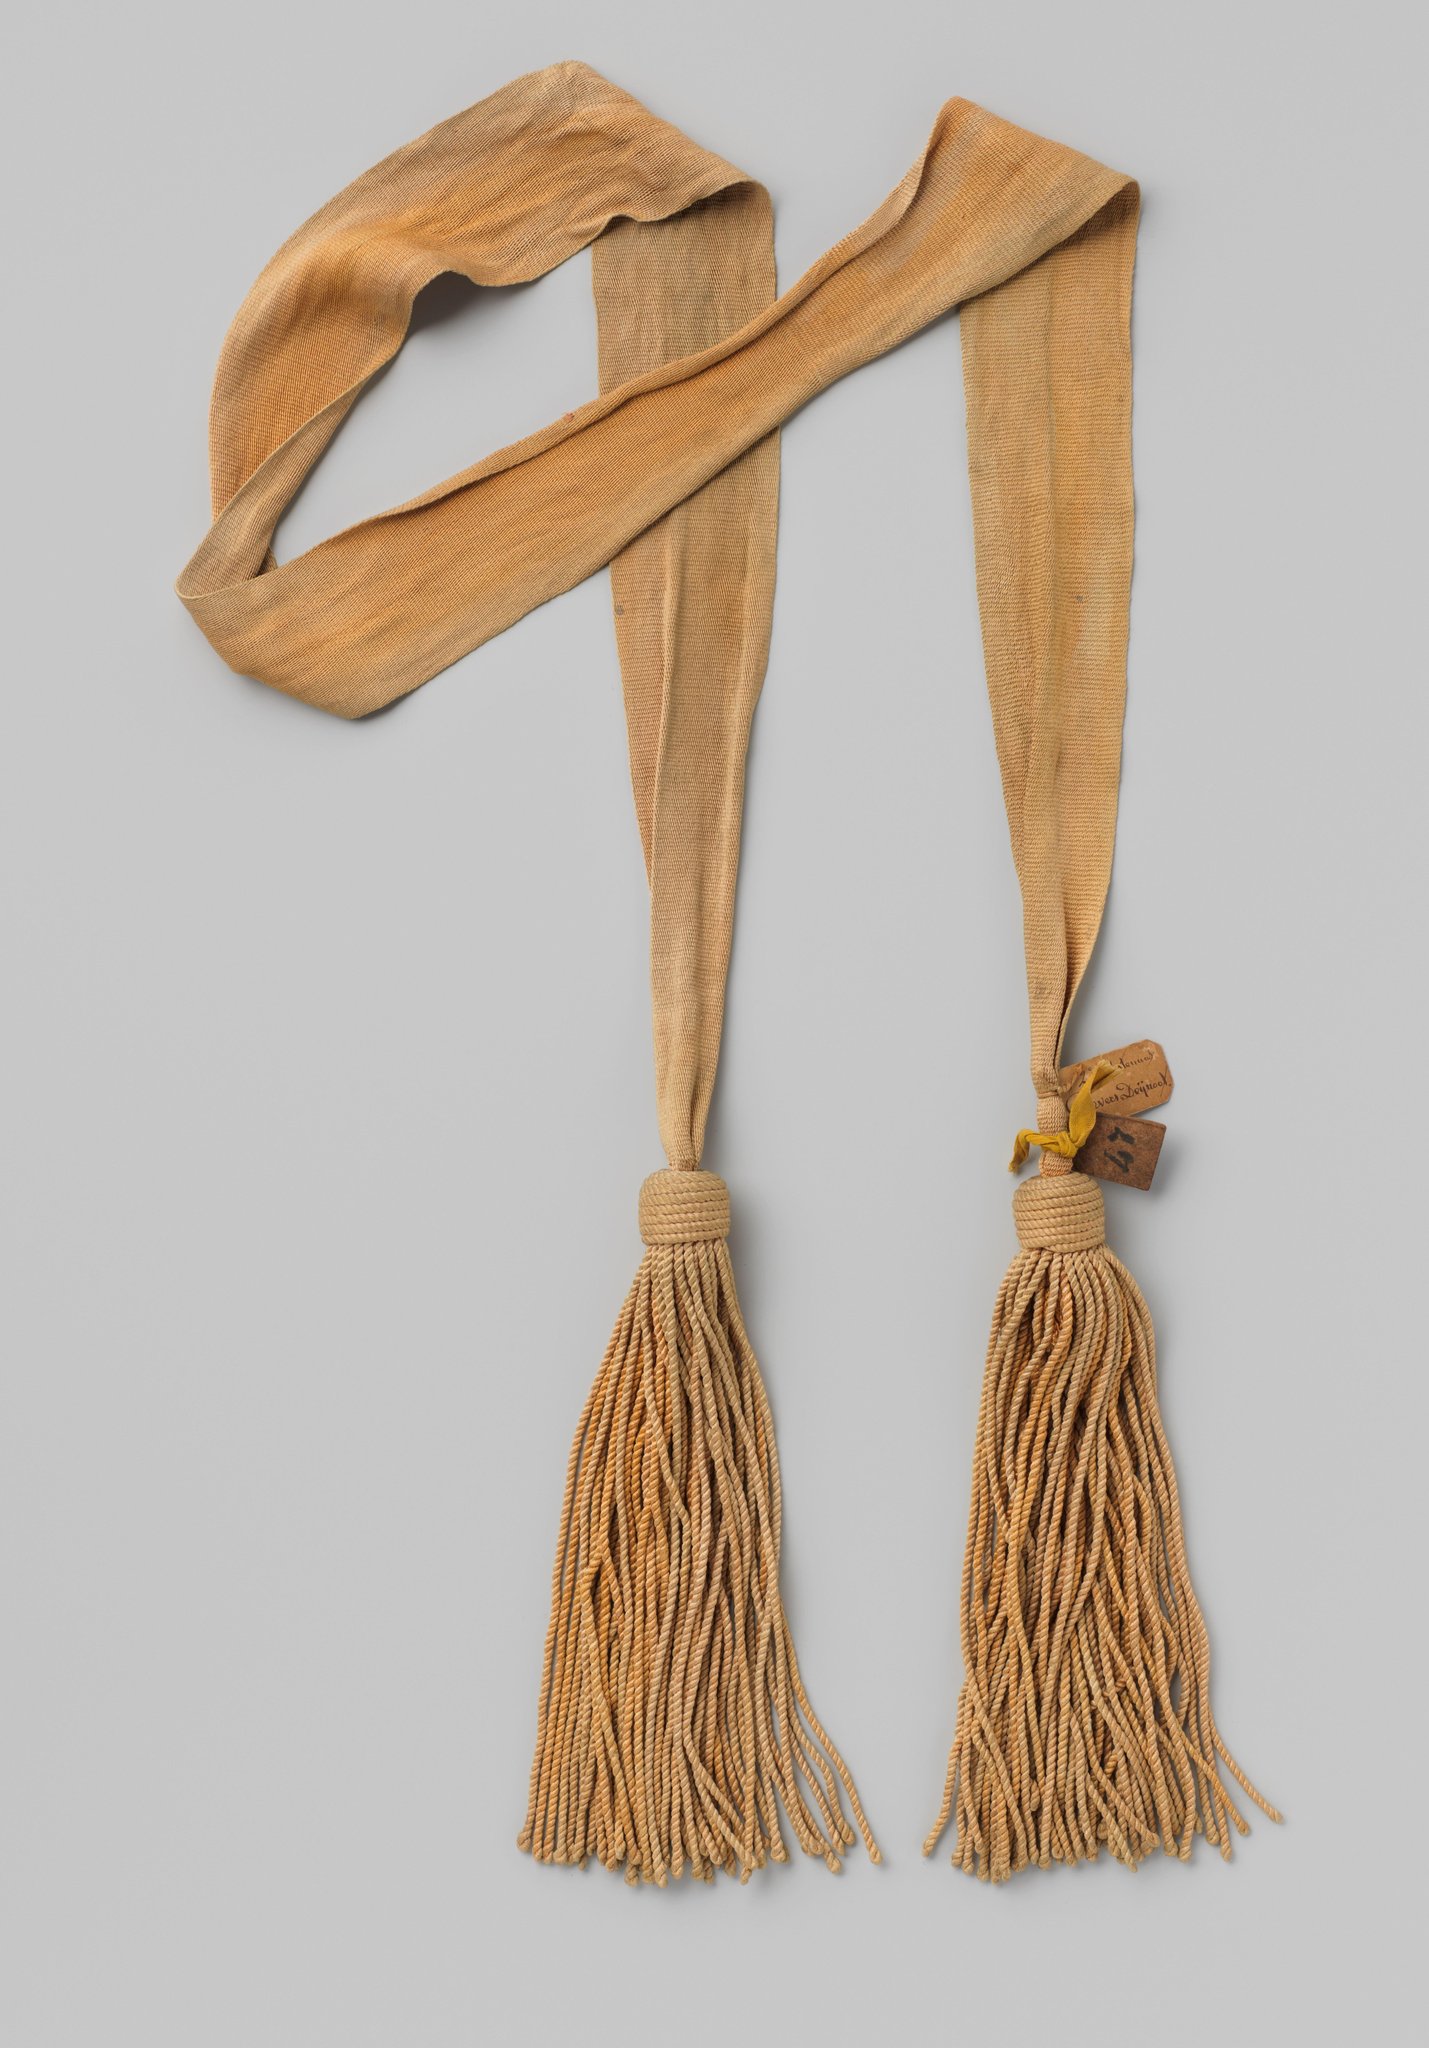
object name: sash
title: Sjerp voor officieren (mobiele schutterij?), ca. 1850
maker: Anonymous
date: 1850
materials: silk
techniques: stitching, weave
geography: netherlands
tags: gevers deijnoot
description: Sjerp van verfletst oranje koordzijde in techniek van Egyptisch vlechtwerk. Aan beide uiteinden kwasten van dito zijde, met lange afhangende franjes.